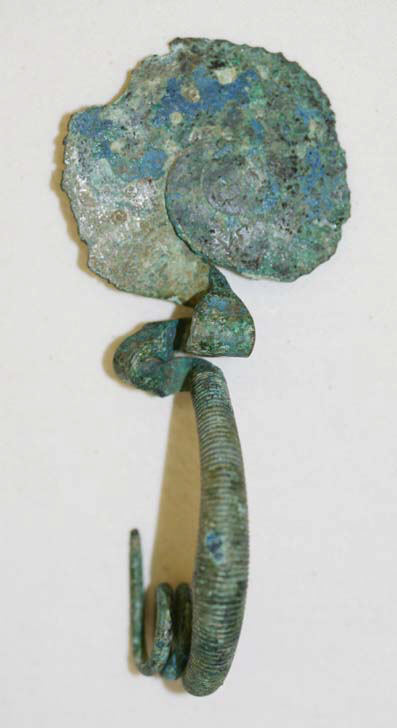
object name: pin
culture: european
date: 400-301 BCE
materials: bronze